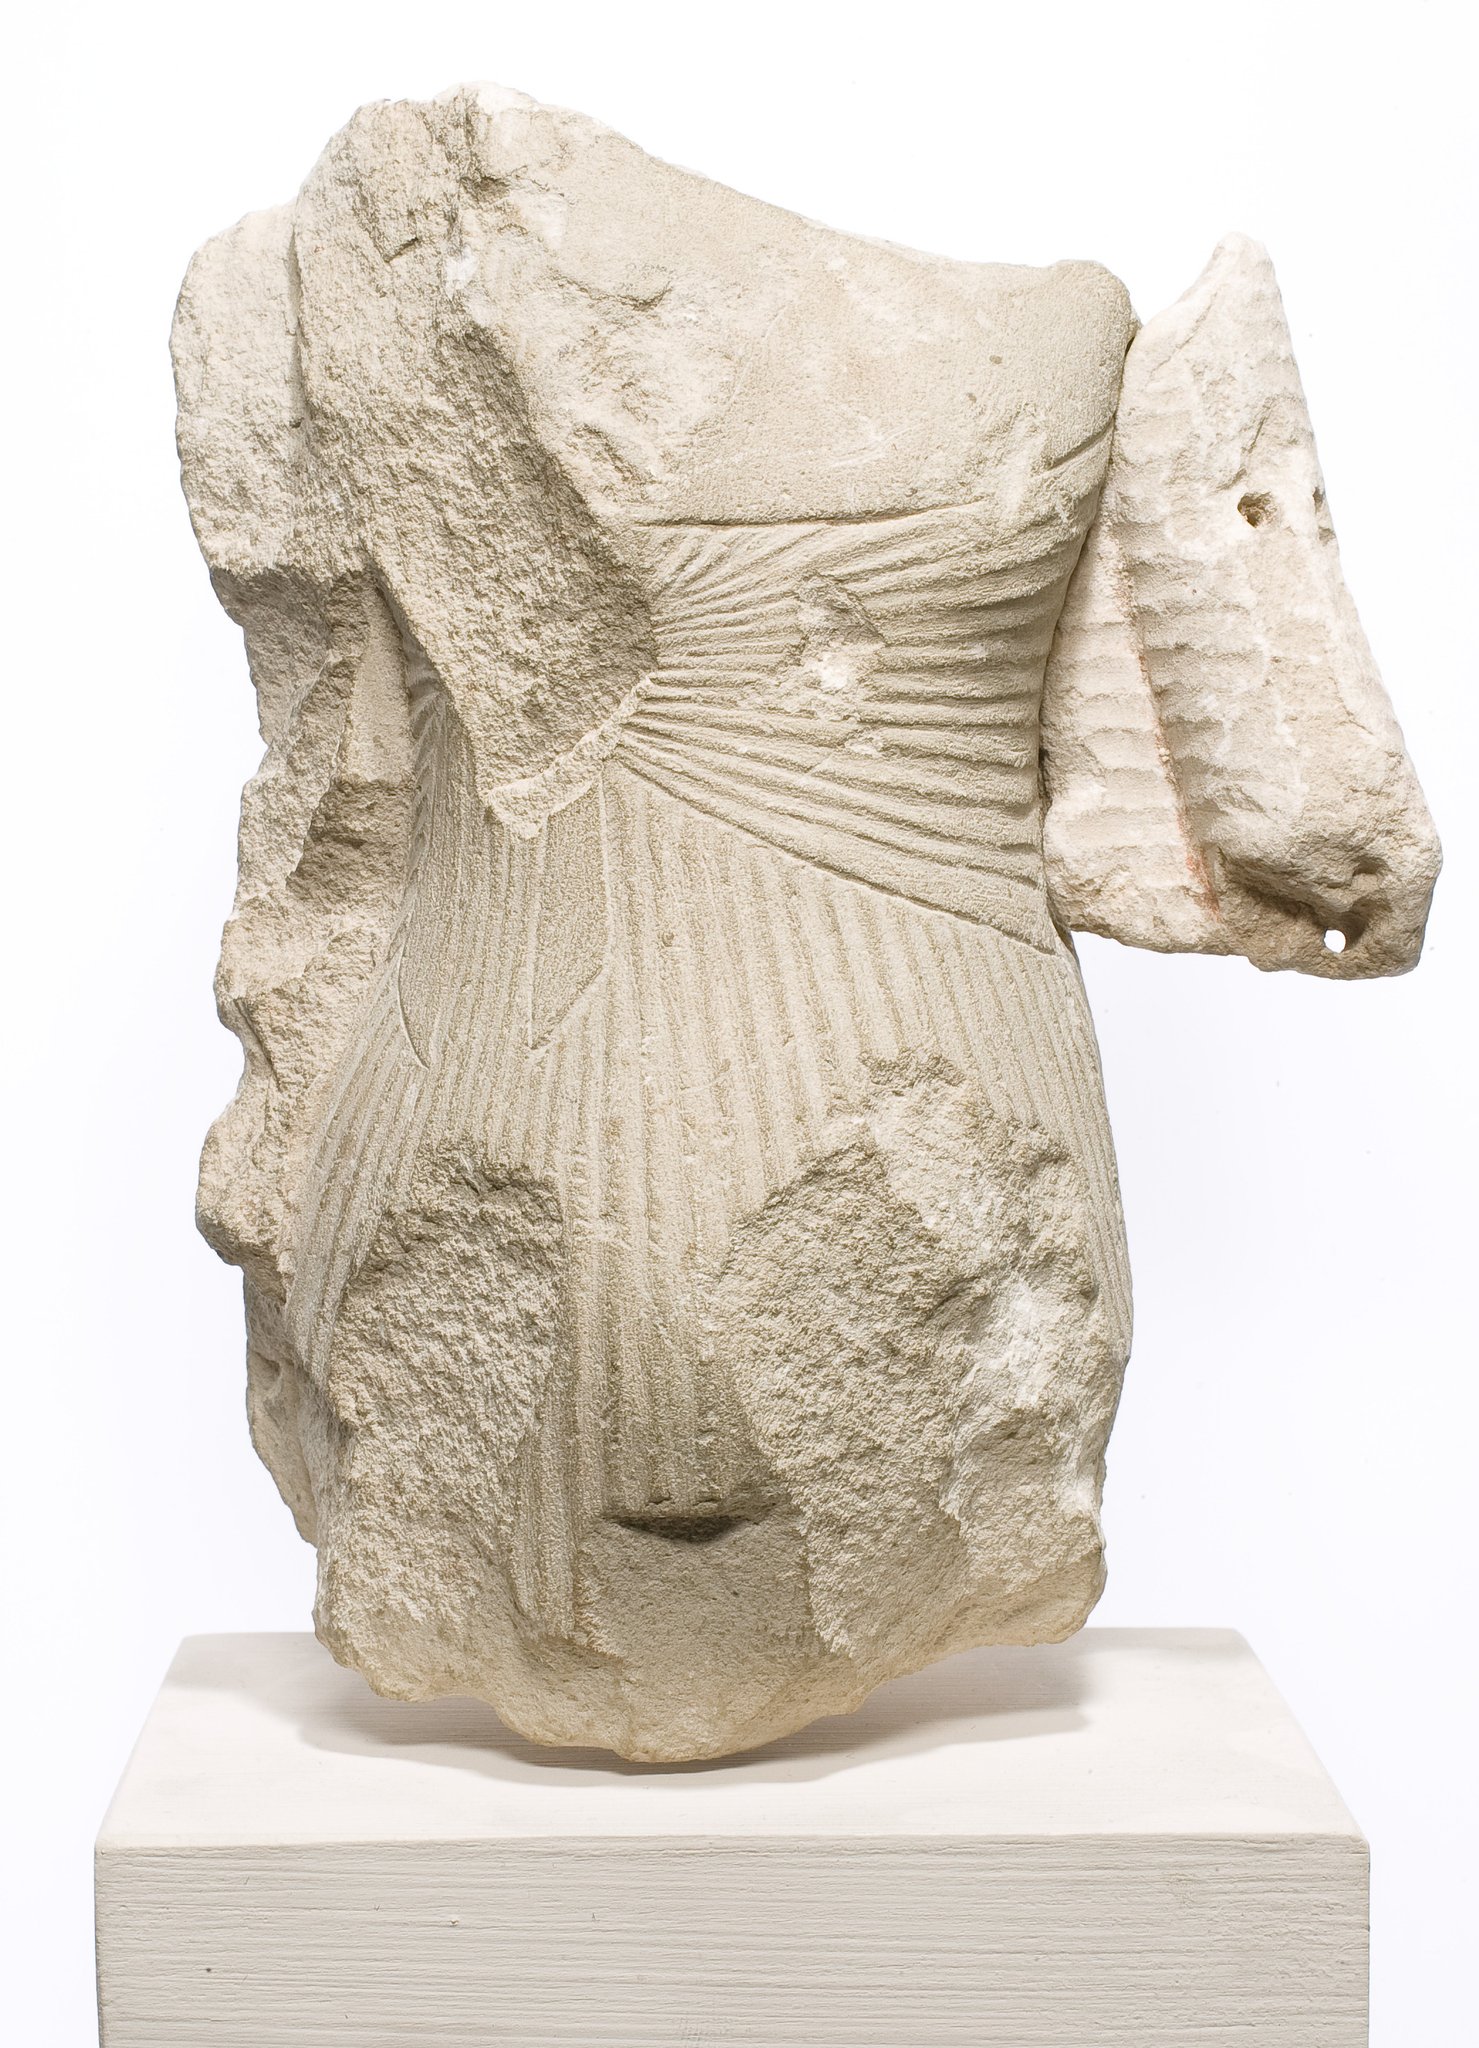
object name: princess torso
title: Princess(?) torso with garment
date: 1352-1336 BCE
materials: limestone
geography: egypt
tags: princesses